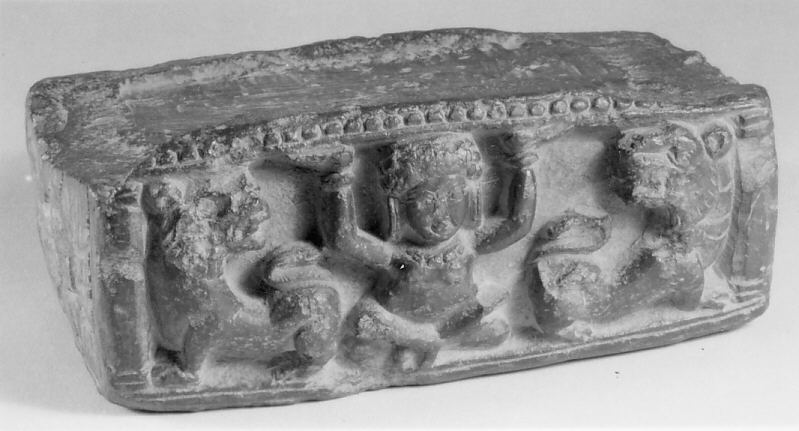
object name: pedestal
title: Pedestal with Yaksha and Two Lions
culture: kashmiri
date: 801-900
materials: stone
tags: kashmir,lions